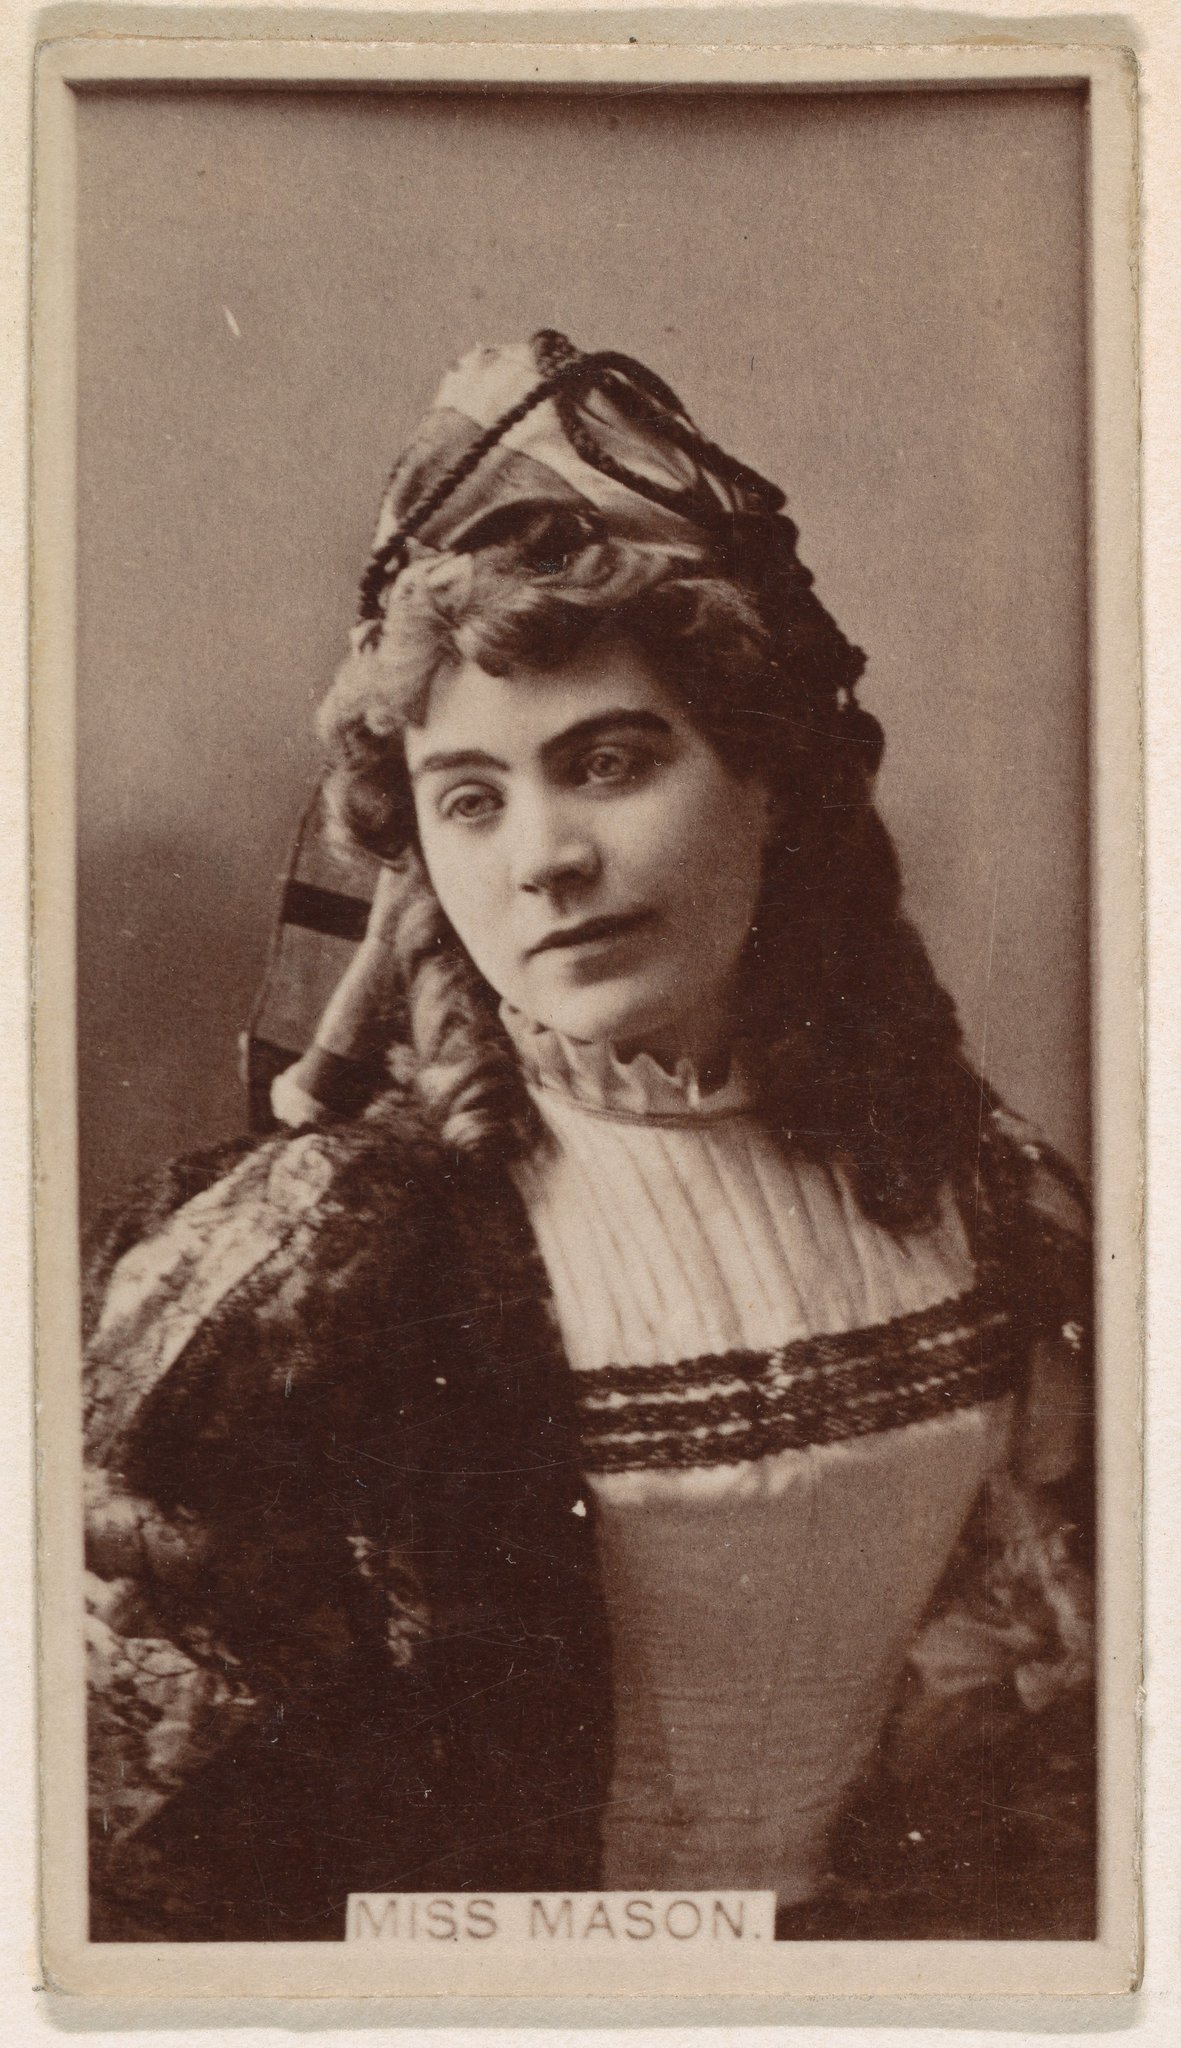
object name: photograph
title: Miss Mason, from the Actresses series (N245) issued by Kinney Brothers to promote Sweet Caporal Cigarettes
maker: kinney brothers tobacco company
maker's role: publisher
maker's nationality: american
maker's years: 1869-2011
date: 1890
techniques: albumen silver print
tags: portraits,women,actresses